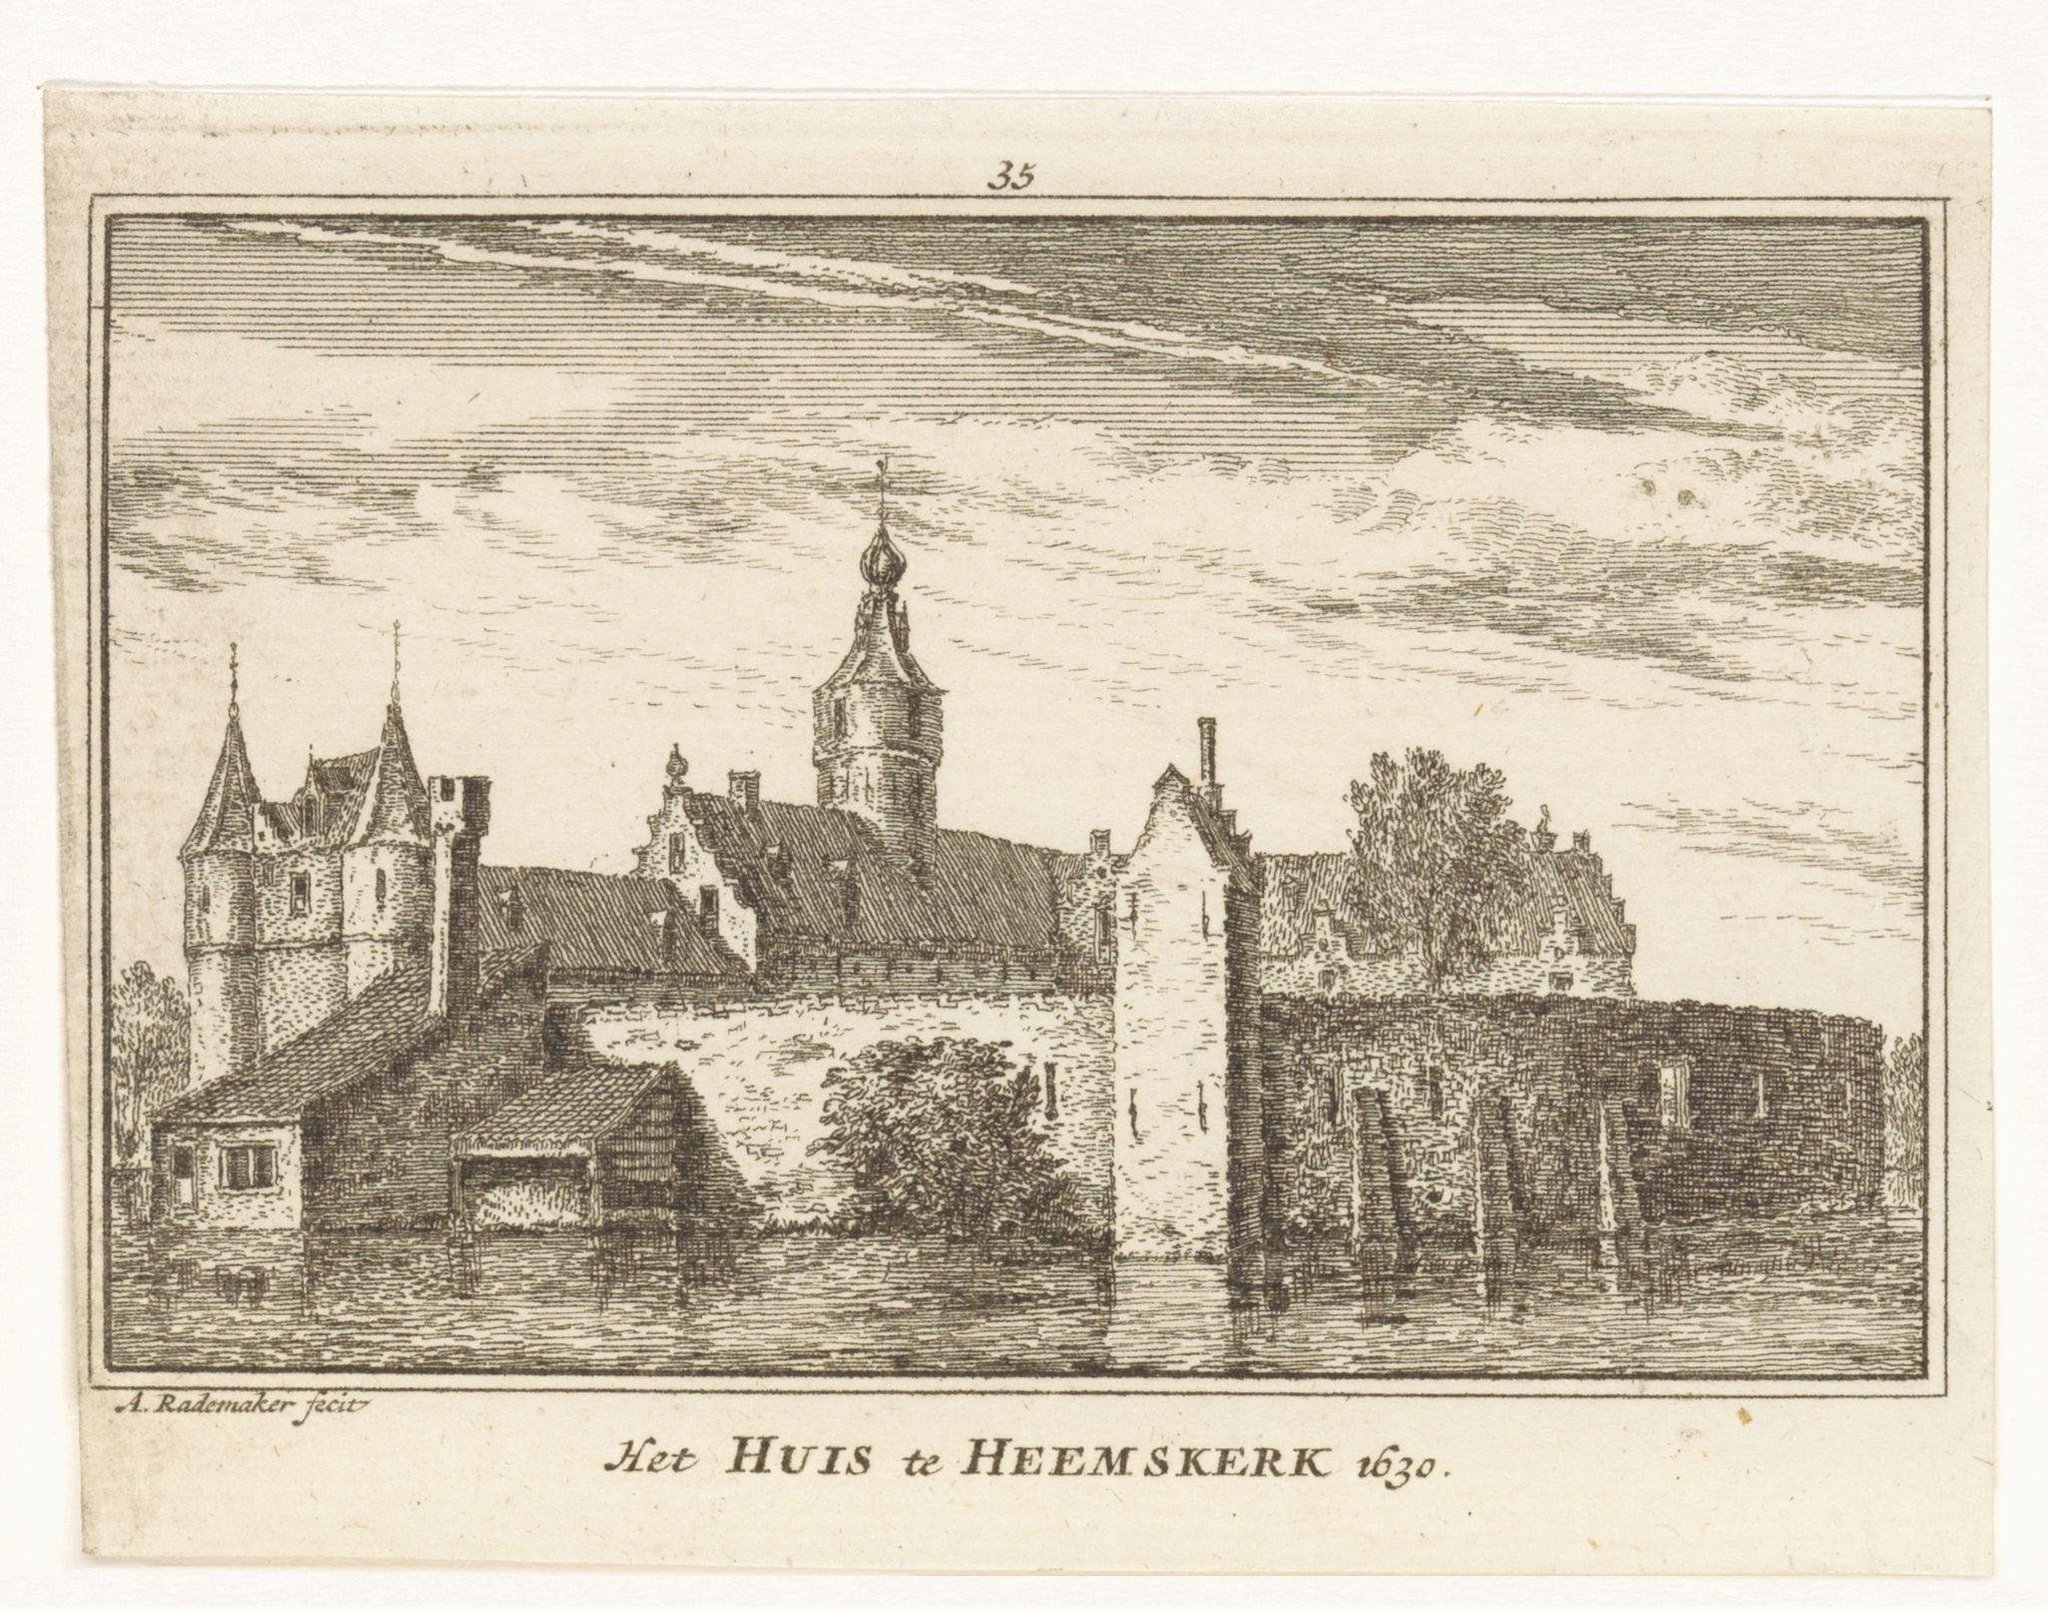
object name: print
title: Het Huis te Heemskerk 1630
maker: abraham rademaker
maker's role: draughtsman, print maker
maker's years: 1676-1735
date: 1725-1803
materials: paper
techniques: engraving, etching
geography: amsterdam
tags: castle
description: Prent ook gebruikt in: Rademaker, Abraham. Kabinet van Nederlandsche outheden en gezichten: vervat in 300 konstplaaten (…). 2 delen. Amsterdam: Willem Barents, 1725, dl. 1, ill. 35. Na 1725 is deze prent nog in verschillende heruitgaven verschenen, uitgegeven in 1727-1733, 1770-1771 en 1792-1803. Uit welke uitgave het huidige exemplaar precies komt is niet na te gaan.